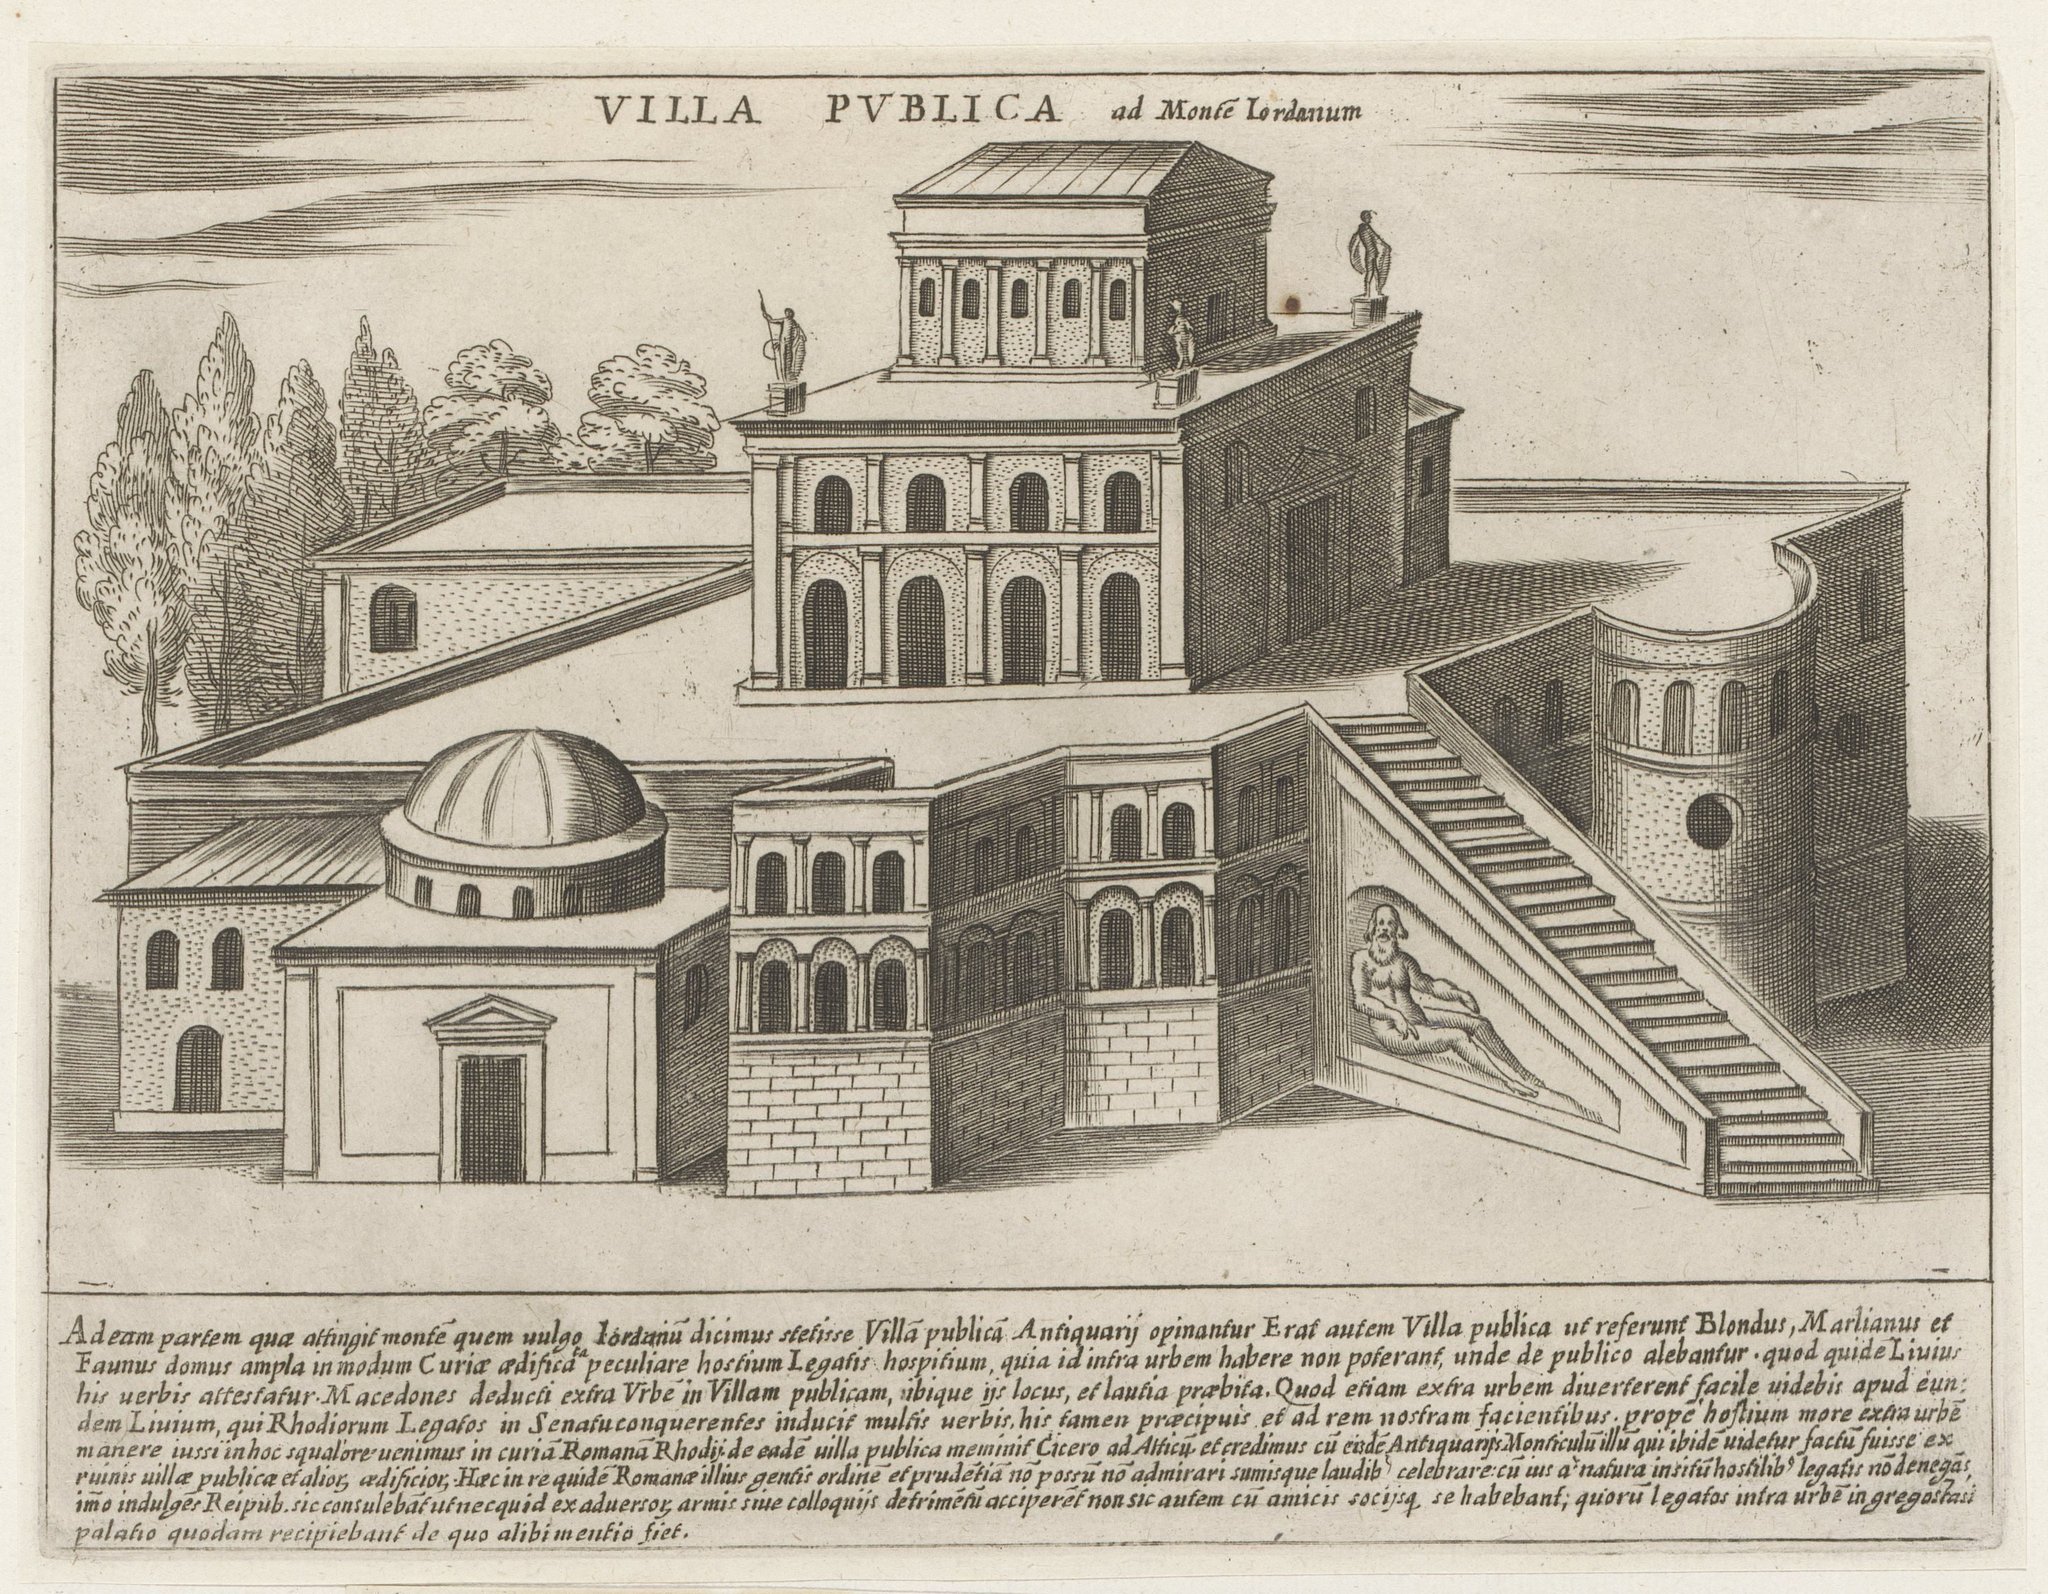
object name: album leaf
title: Villa Publica ad Monte Lordanum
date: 1612-1628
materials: paper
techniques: etching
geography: rome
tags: villa, representation of real building (either existing or having existed)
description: Deze prent maakt deel uit van een set van 158 prenten (+ titelprenten), die verscheen in vier delen. In 1612 verschenen delen één en twee. In 1615 verscheen het derde deel en in 1628 verscheen deel vier. In 1637 publiceerde Vitale Mascardi de eerste heruitgave van de gehele set met nummering.